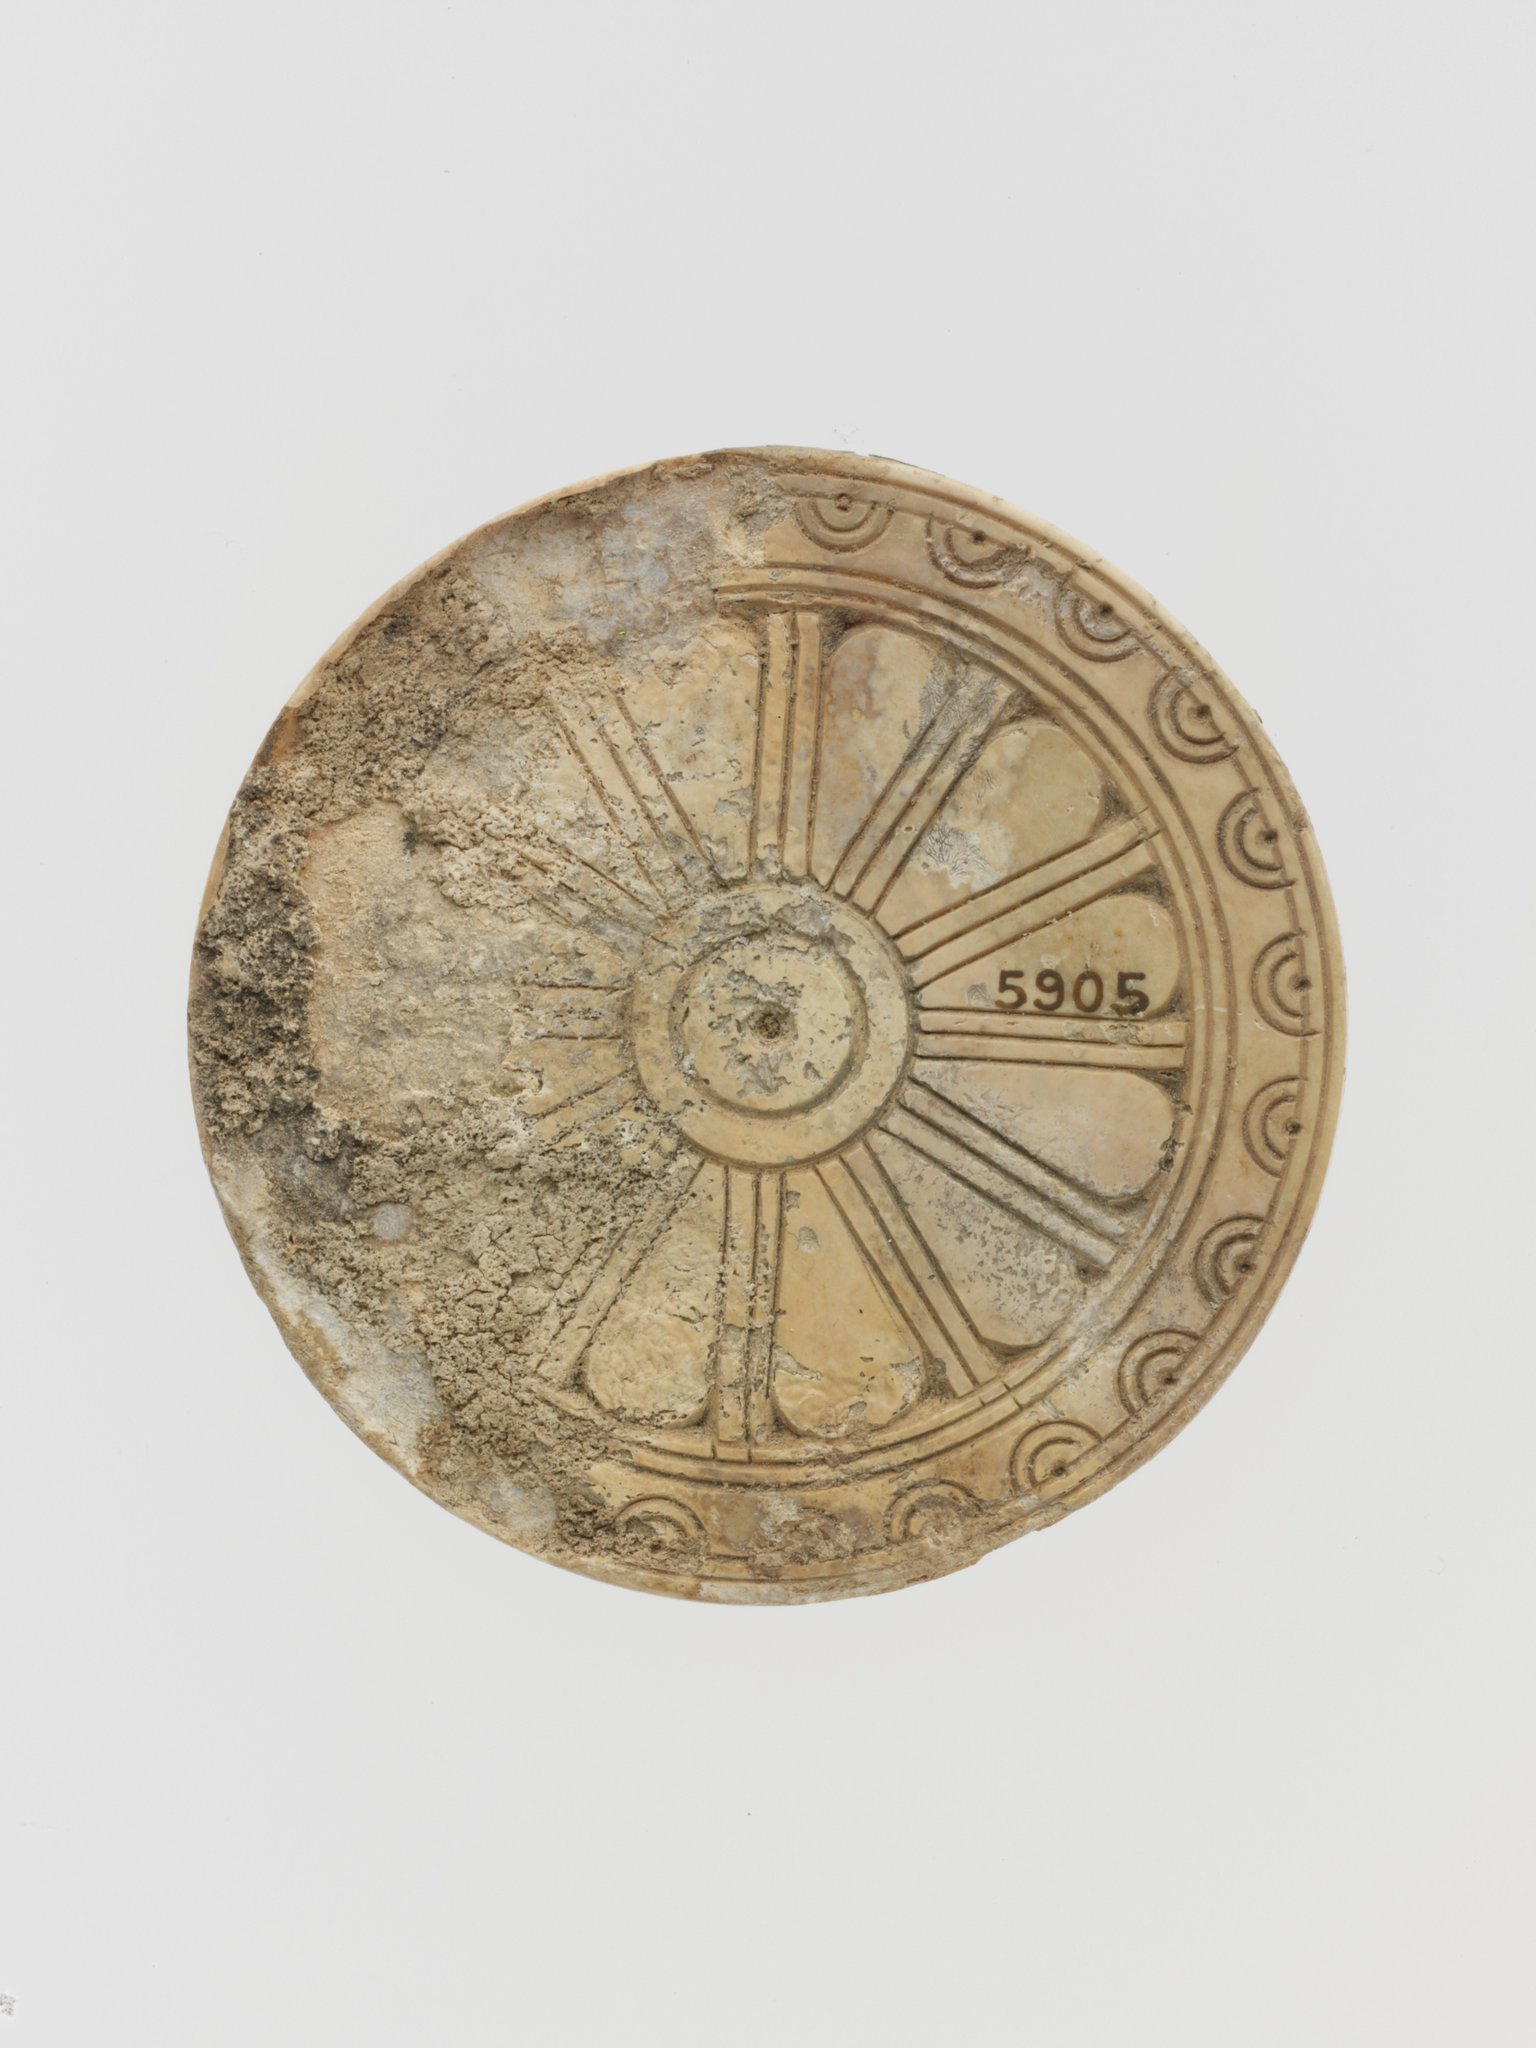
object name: roundel, disk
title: Ivory disk with rosette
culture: cypriot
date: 1300-1101 BCE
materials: ivory